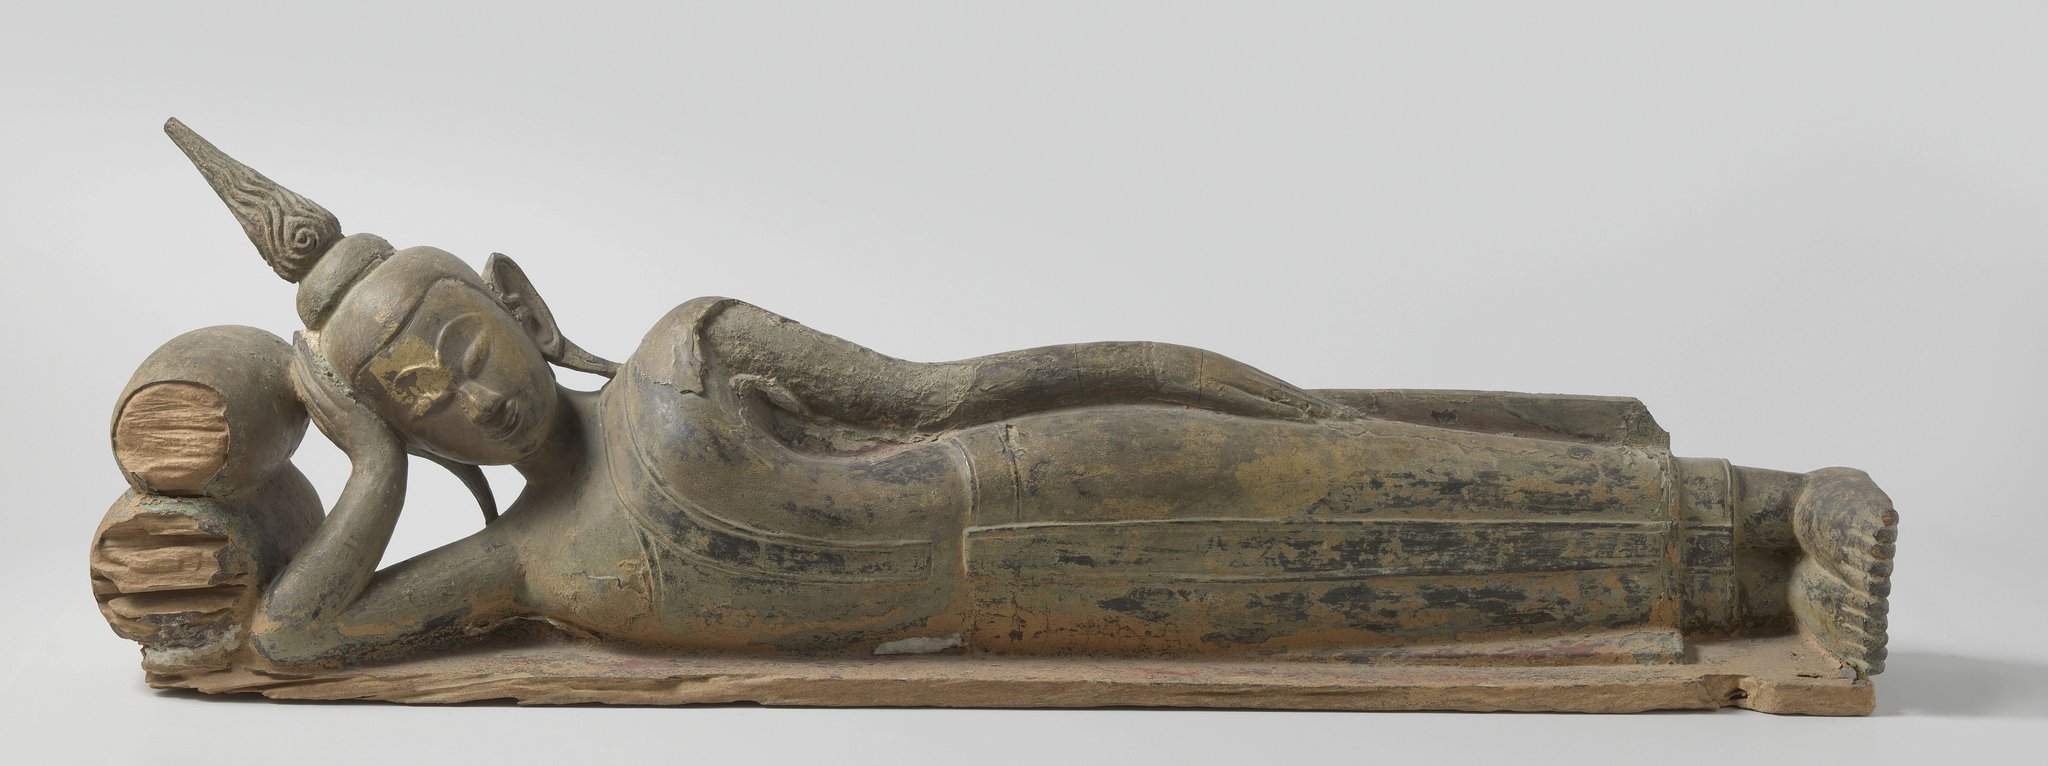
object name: boeddha kop, boeddha beeld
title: Liggende Boeddha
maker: Anonymous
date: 1700-1800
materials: wood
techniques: gilding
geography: bangkok